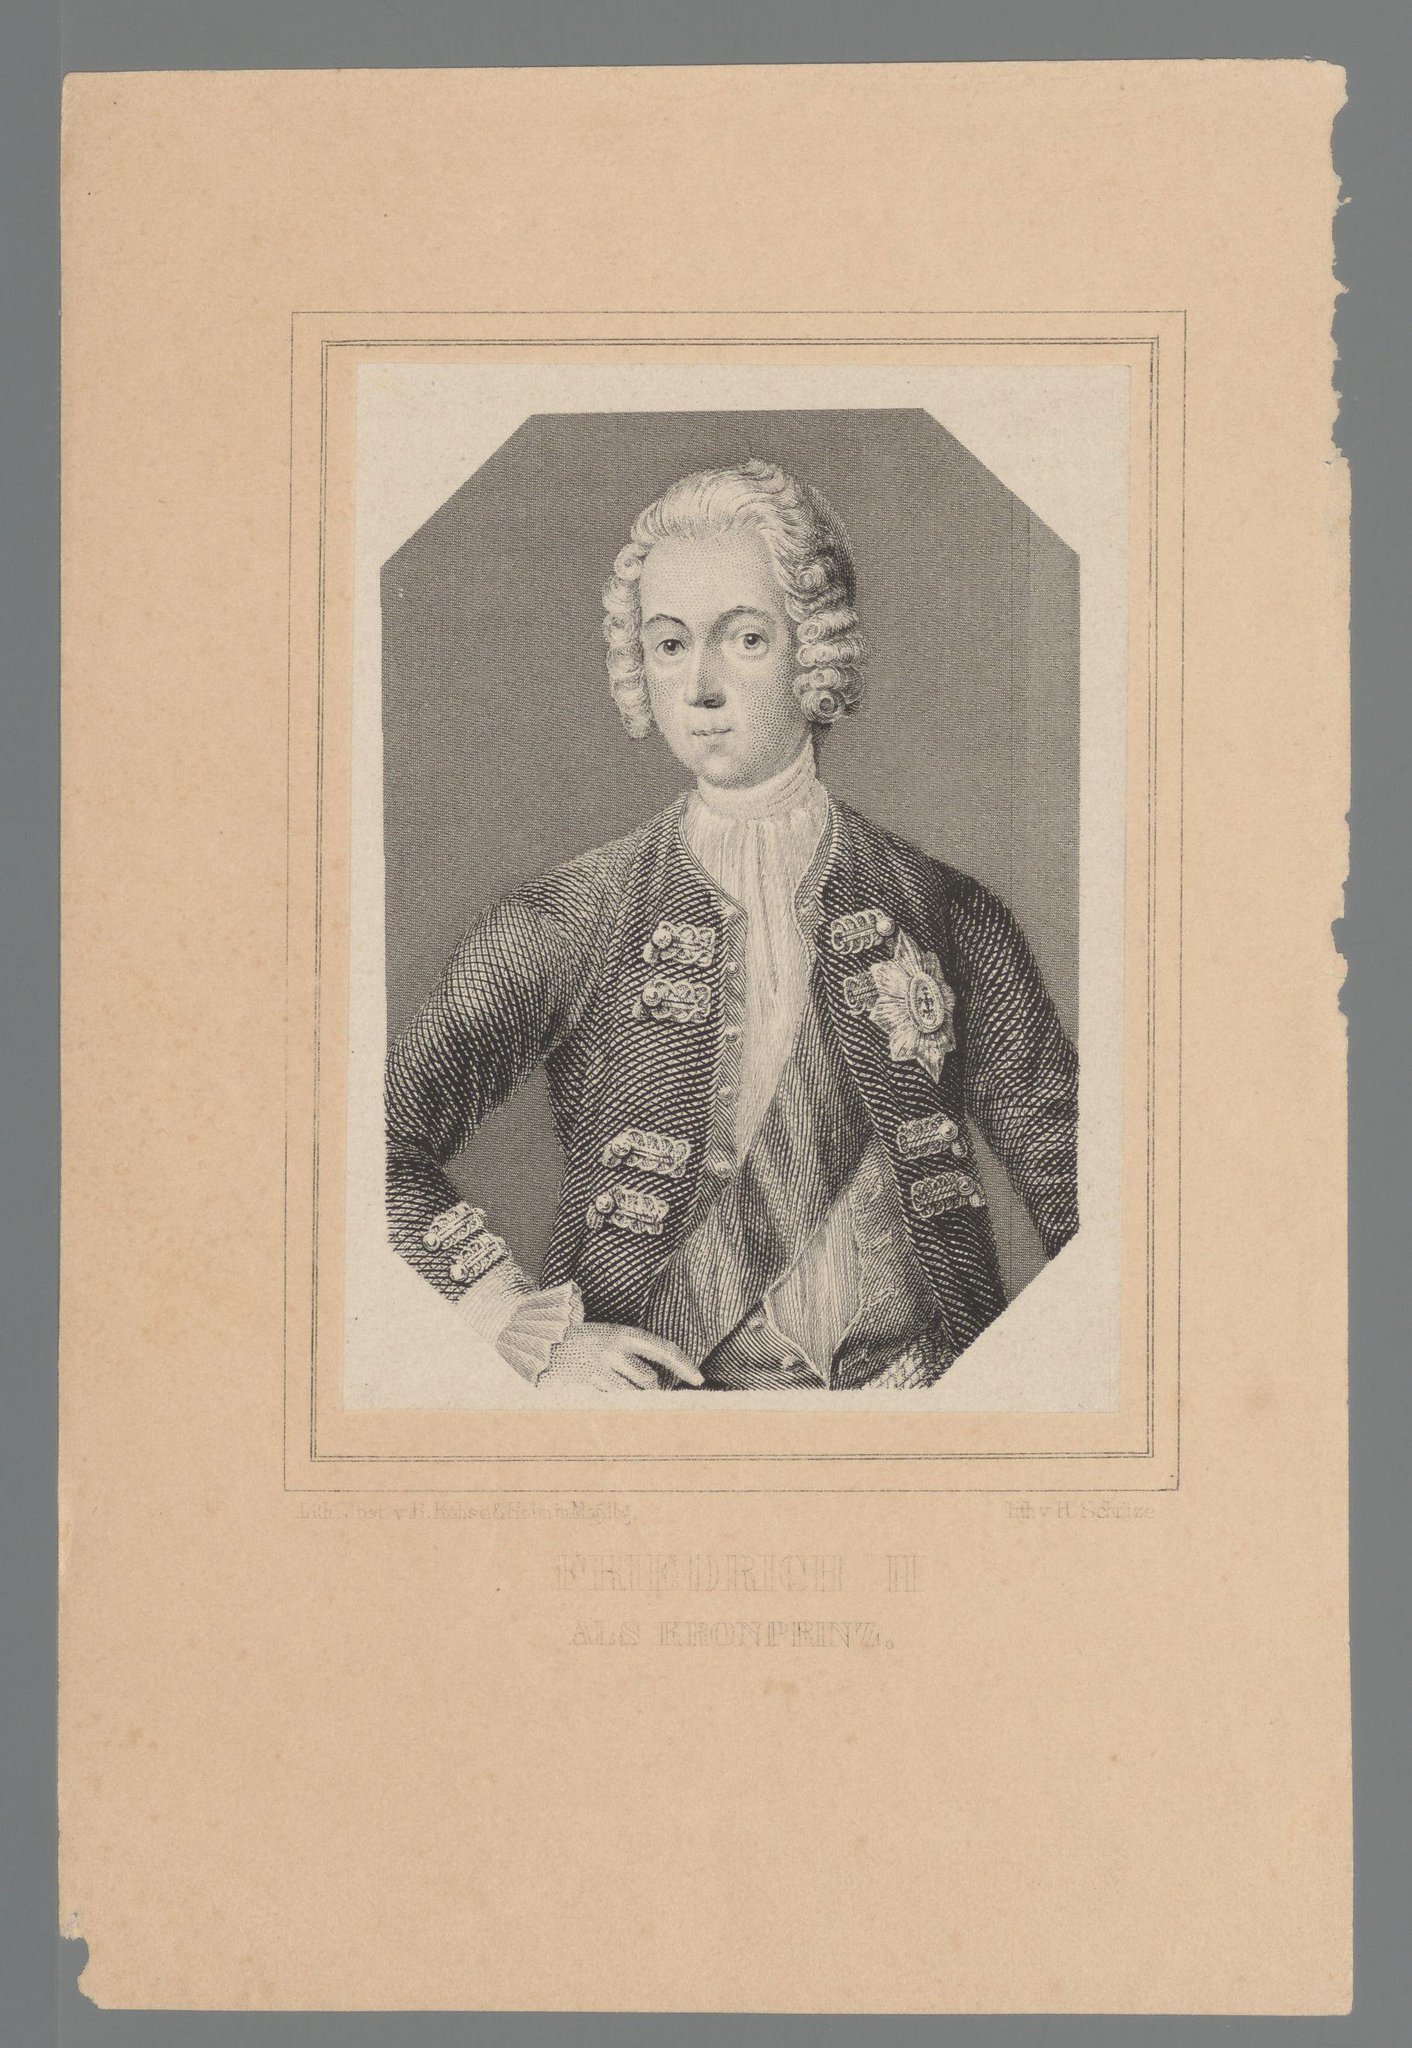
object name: print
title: Portret van Frederik de Grote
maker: h. schuetze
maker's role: print maker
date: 1830-1840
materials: paper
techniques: lithograph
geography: magdeburg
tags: berlin, frederick ii (king of prussia), historical persons, crown prince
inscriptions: collector's mark: Lugt 2228